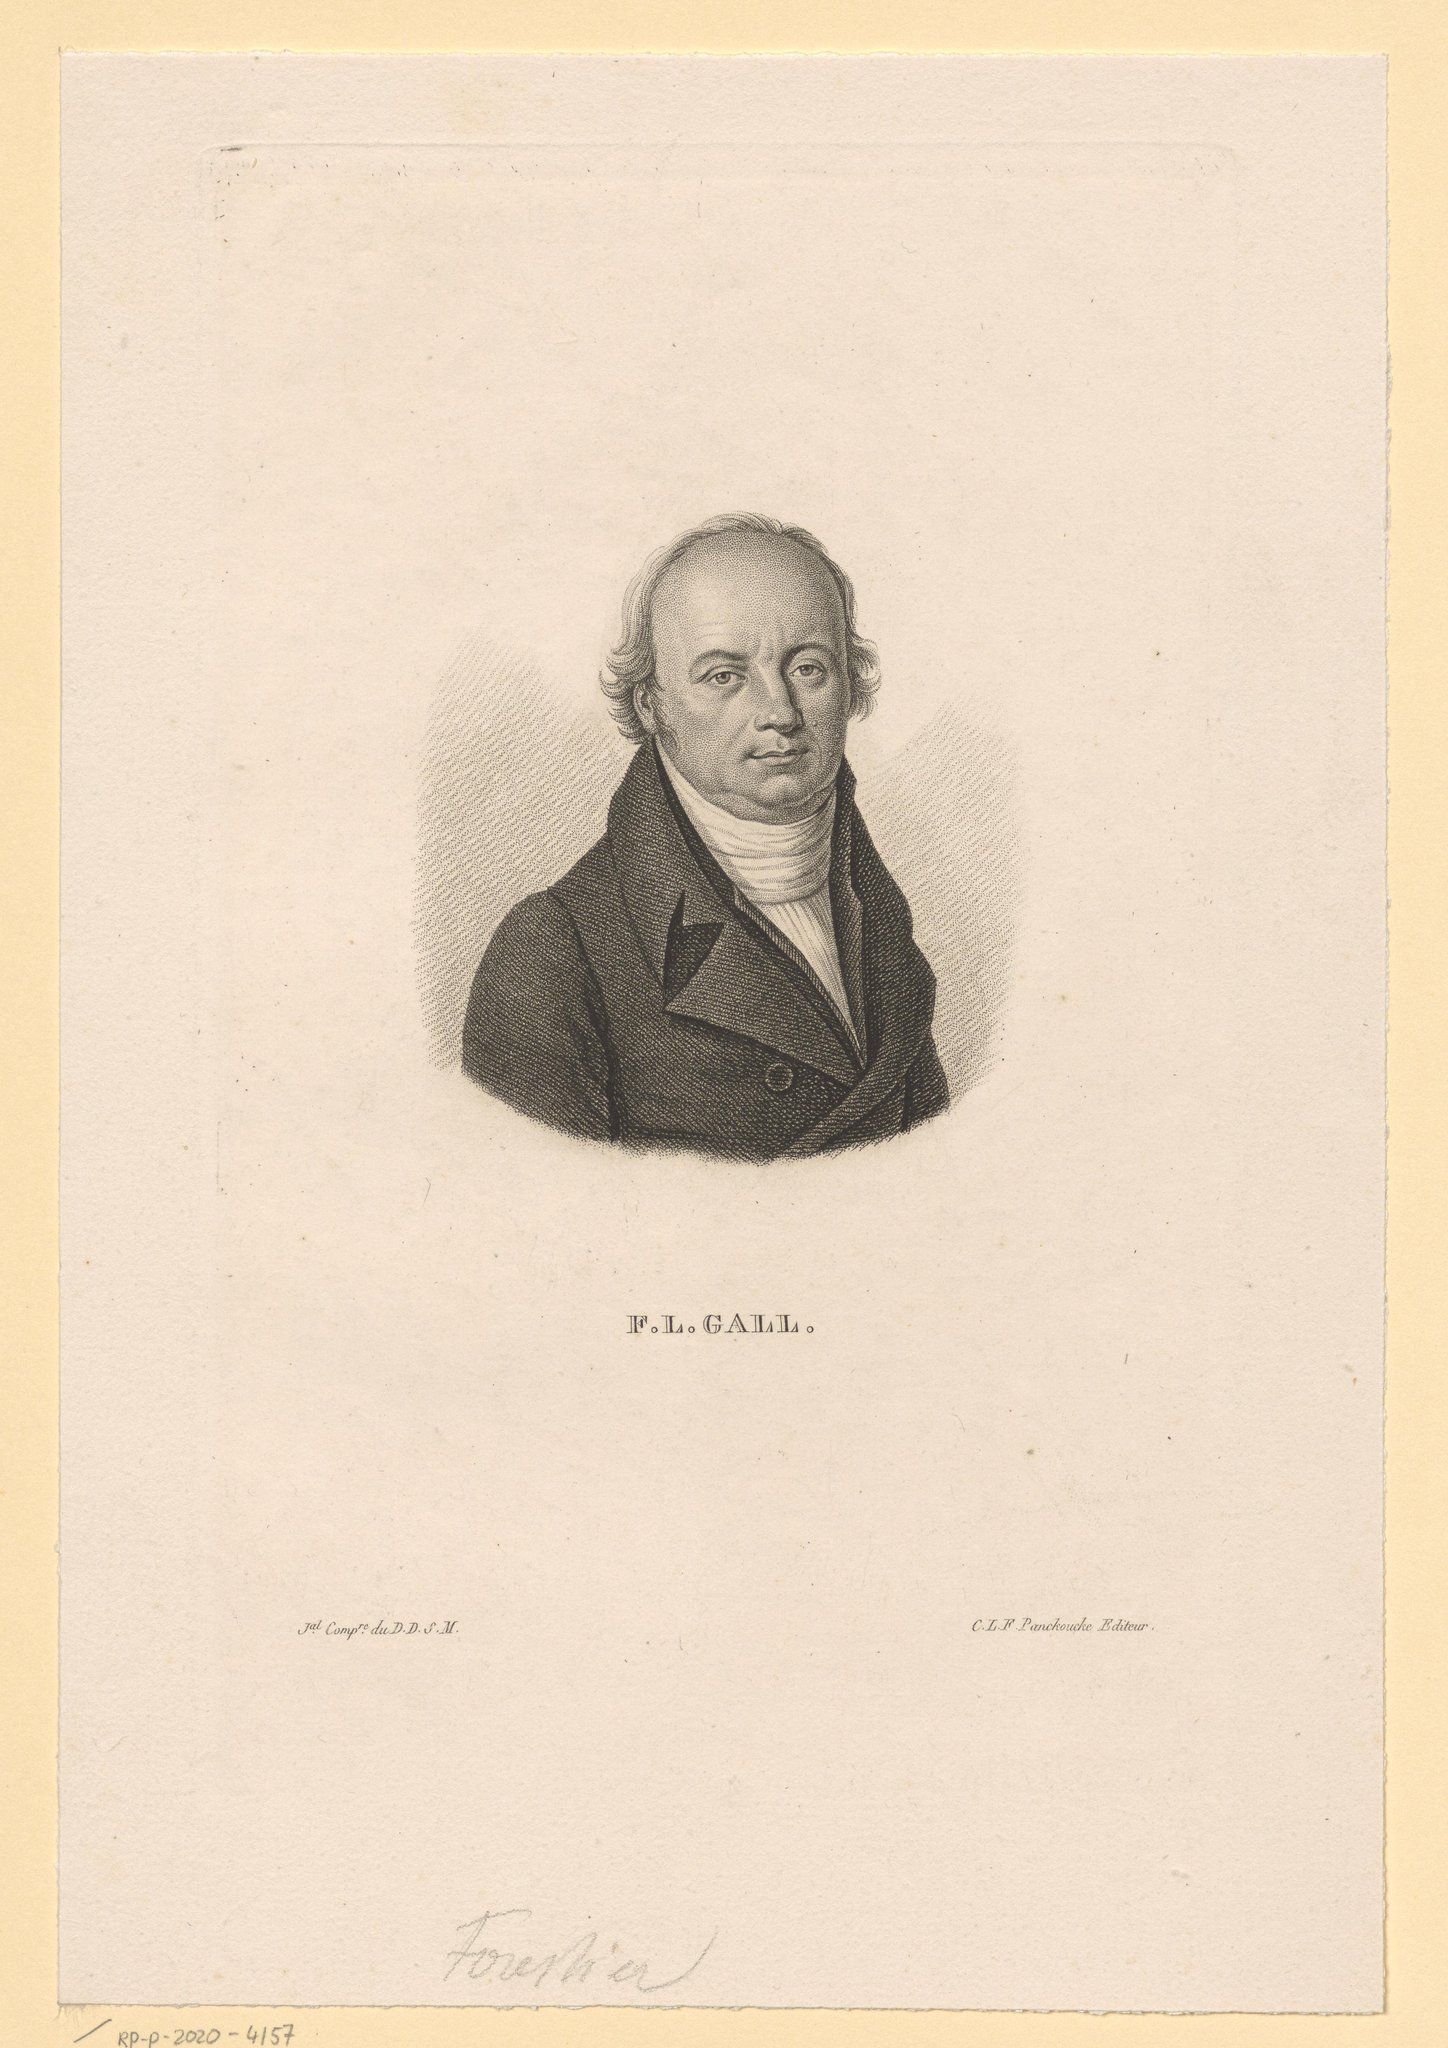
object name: print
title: Portret van Franz Joseph Gall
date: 1780-1844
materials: paper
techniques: engraving, etching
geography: paris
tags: historical persons, physician, doctor (+ portrait of scholar, scientist)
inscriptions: inscription: ‘Jal. Comp.re du D.D. S.M’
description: Prent maakt mogelijk deel uit van een serie.